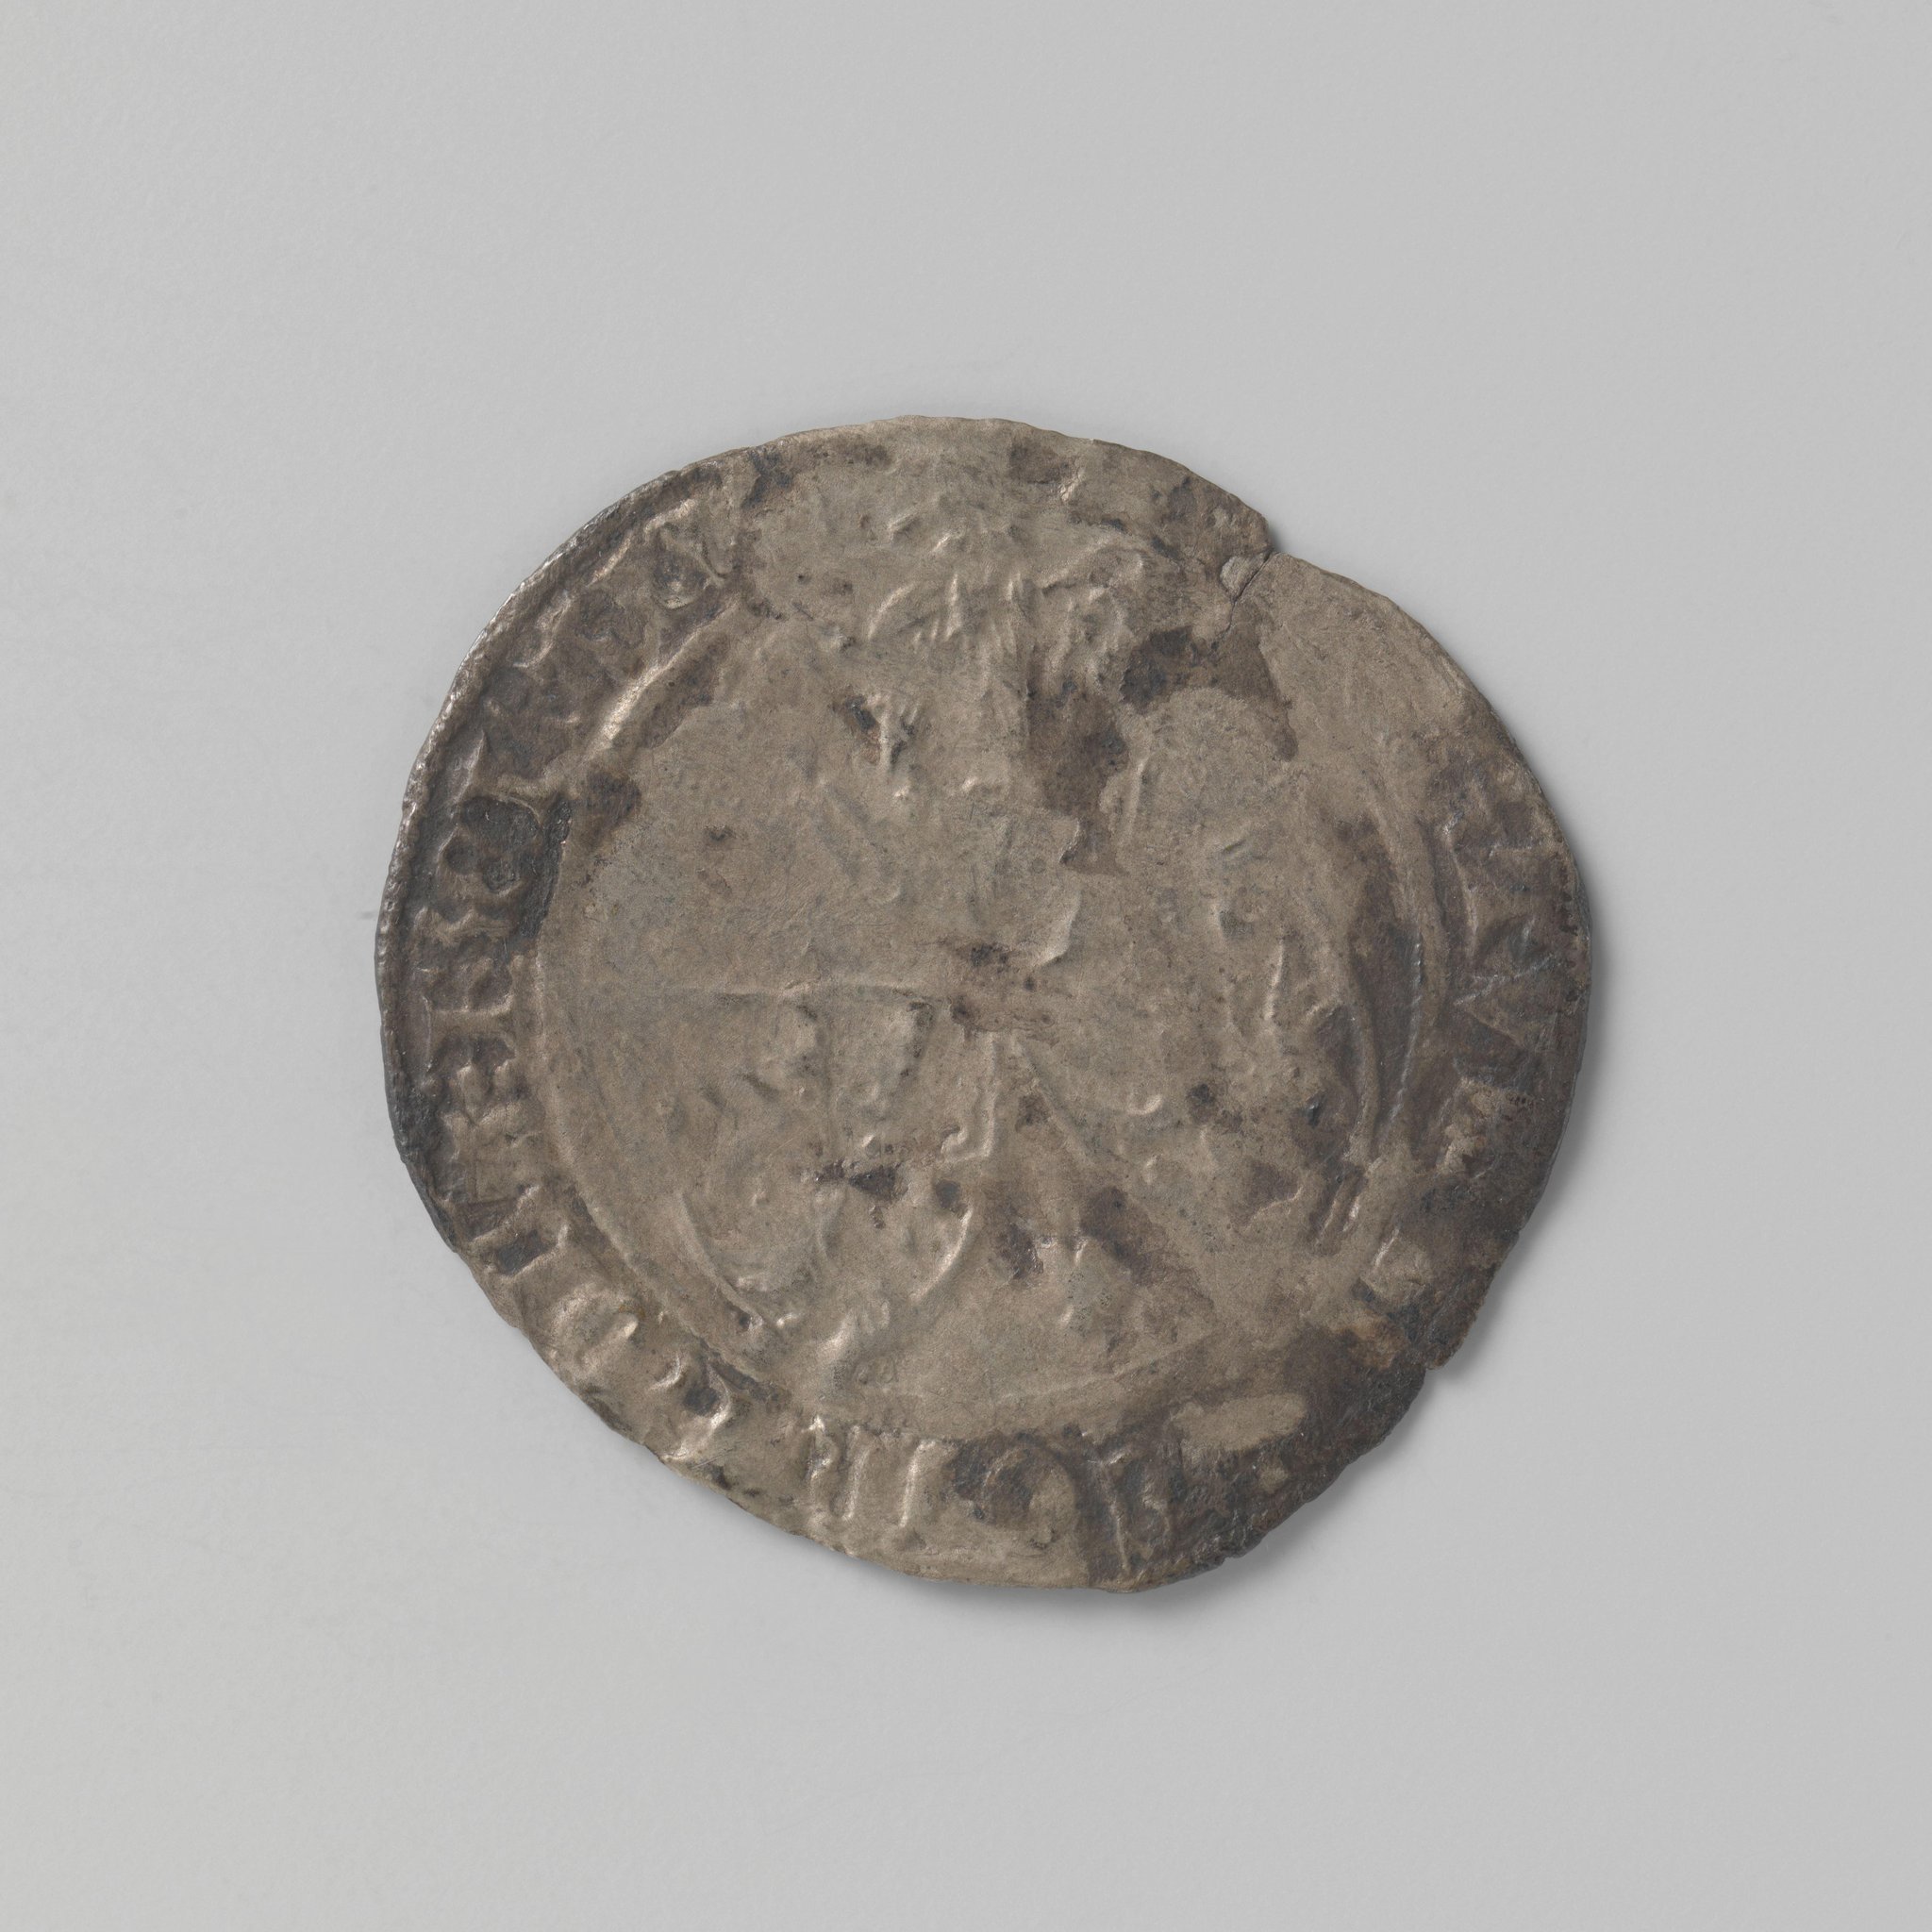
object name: groat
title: Hollandse adelaarsgroot van Albrecht van Beieren, 1389-1404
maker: duke of bavaria albert i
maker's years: 1336-1404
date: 1393-1395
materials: silver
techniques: striking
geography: dordrecht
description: Zilveren munt. Voorzijde: adelaar met in zijn klauwen de wapenschilden van Beieren-Holland en Holland, tussen de wapenschilden een roos. Keerzijde: lang gevoet kruis, in de hoeken letters H, L, A en D.